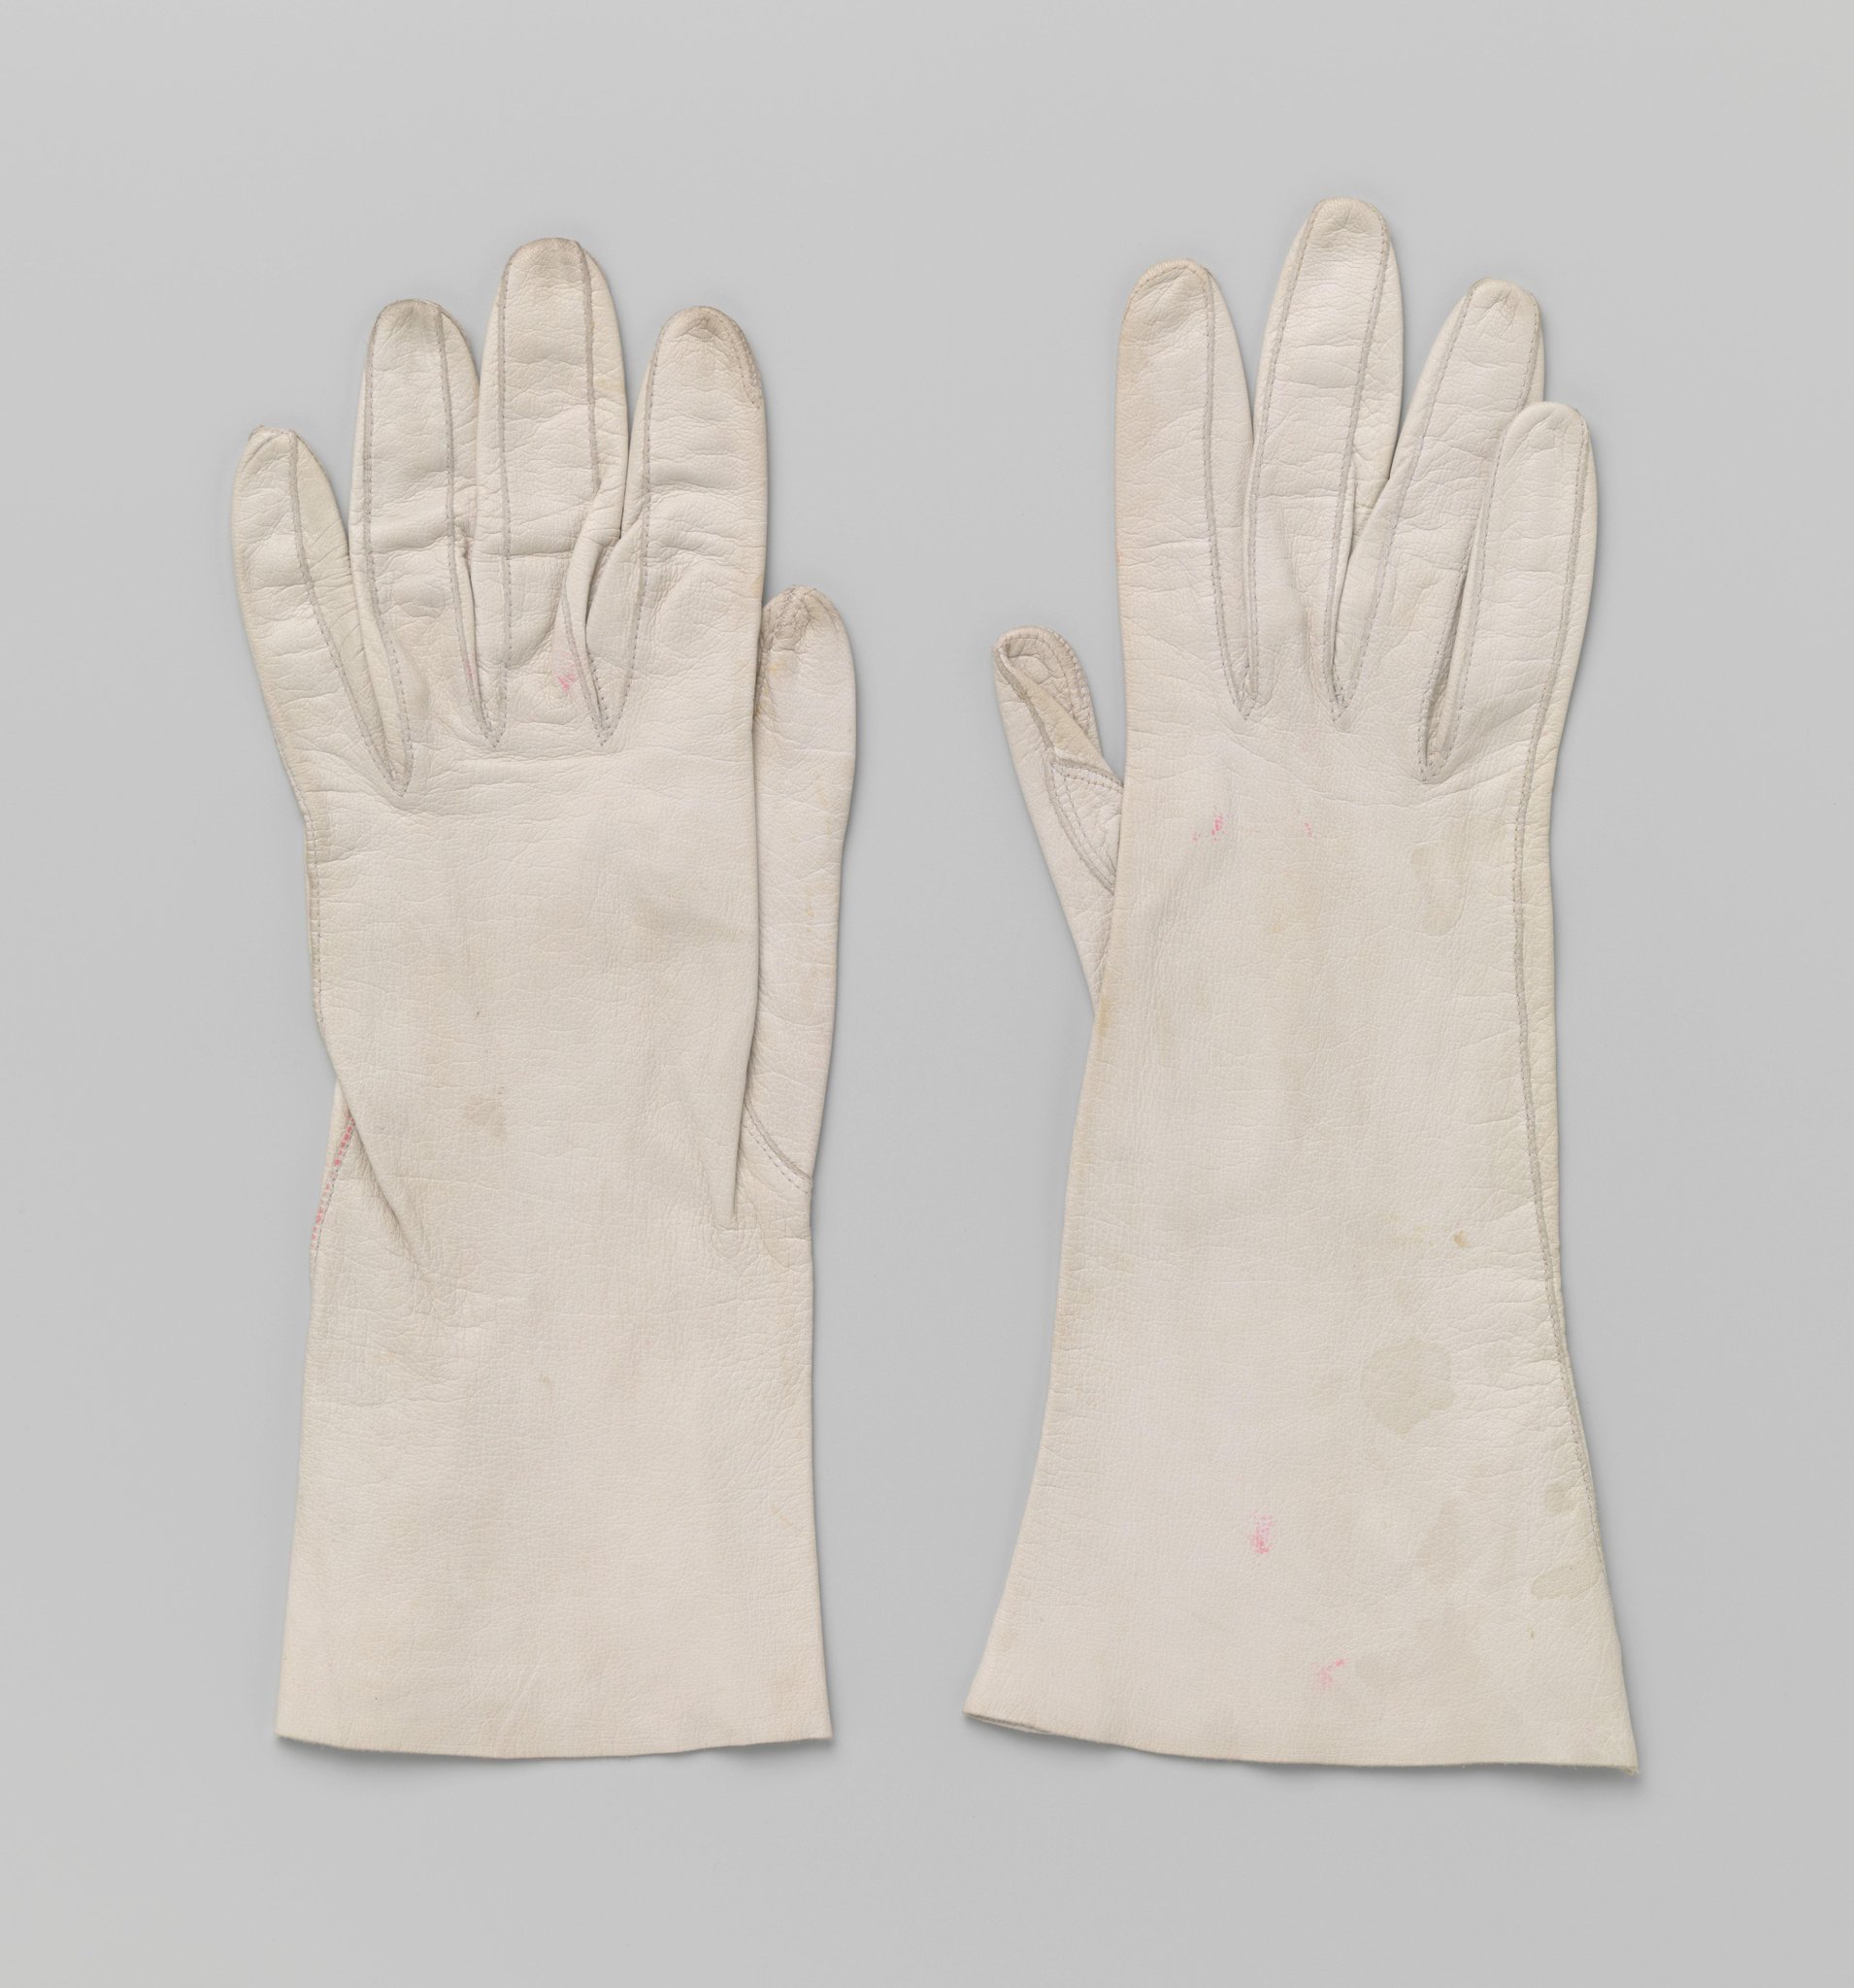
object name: glove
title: Handschoen van wit leer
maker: Anonymous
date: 1900-1915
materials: leather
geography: western europe